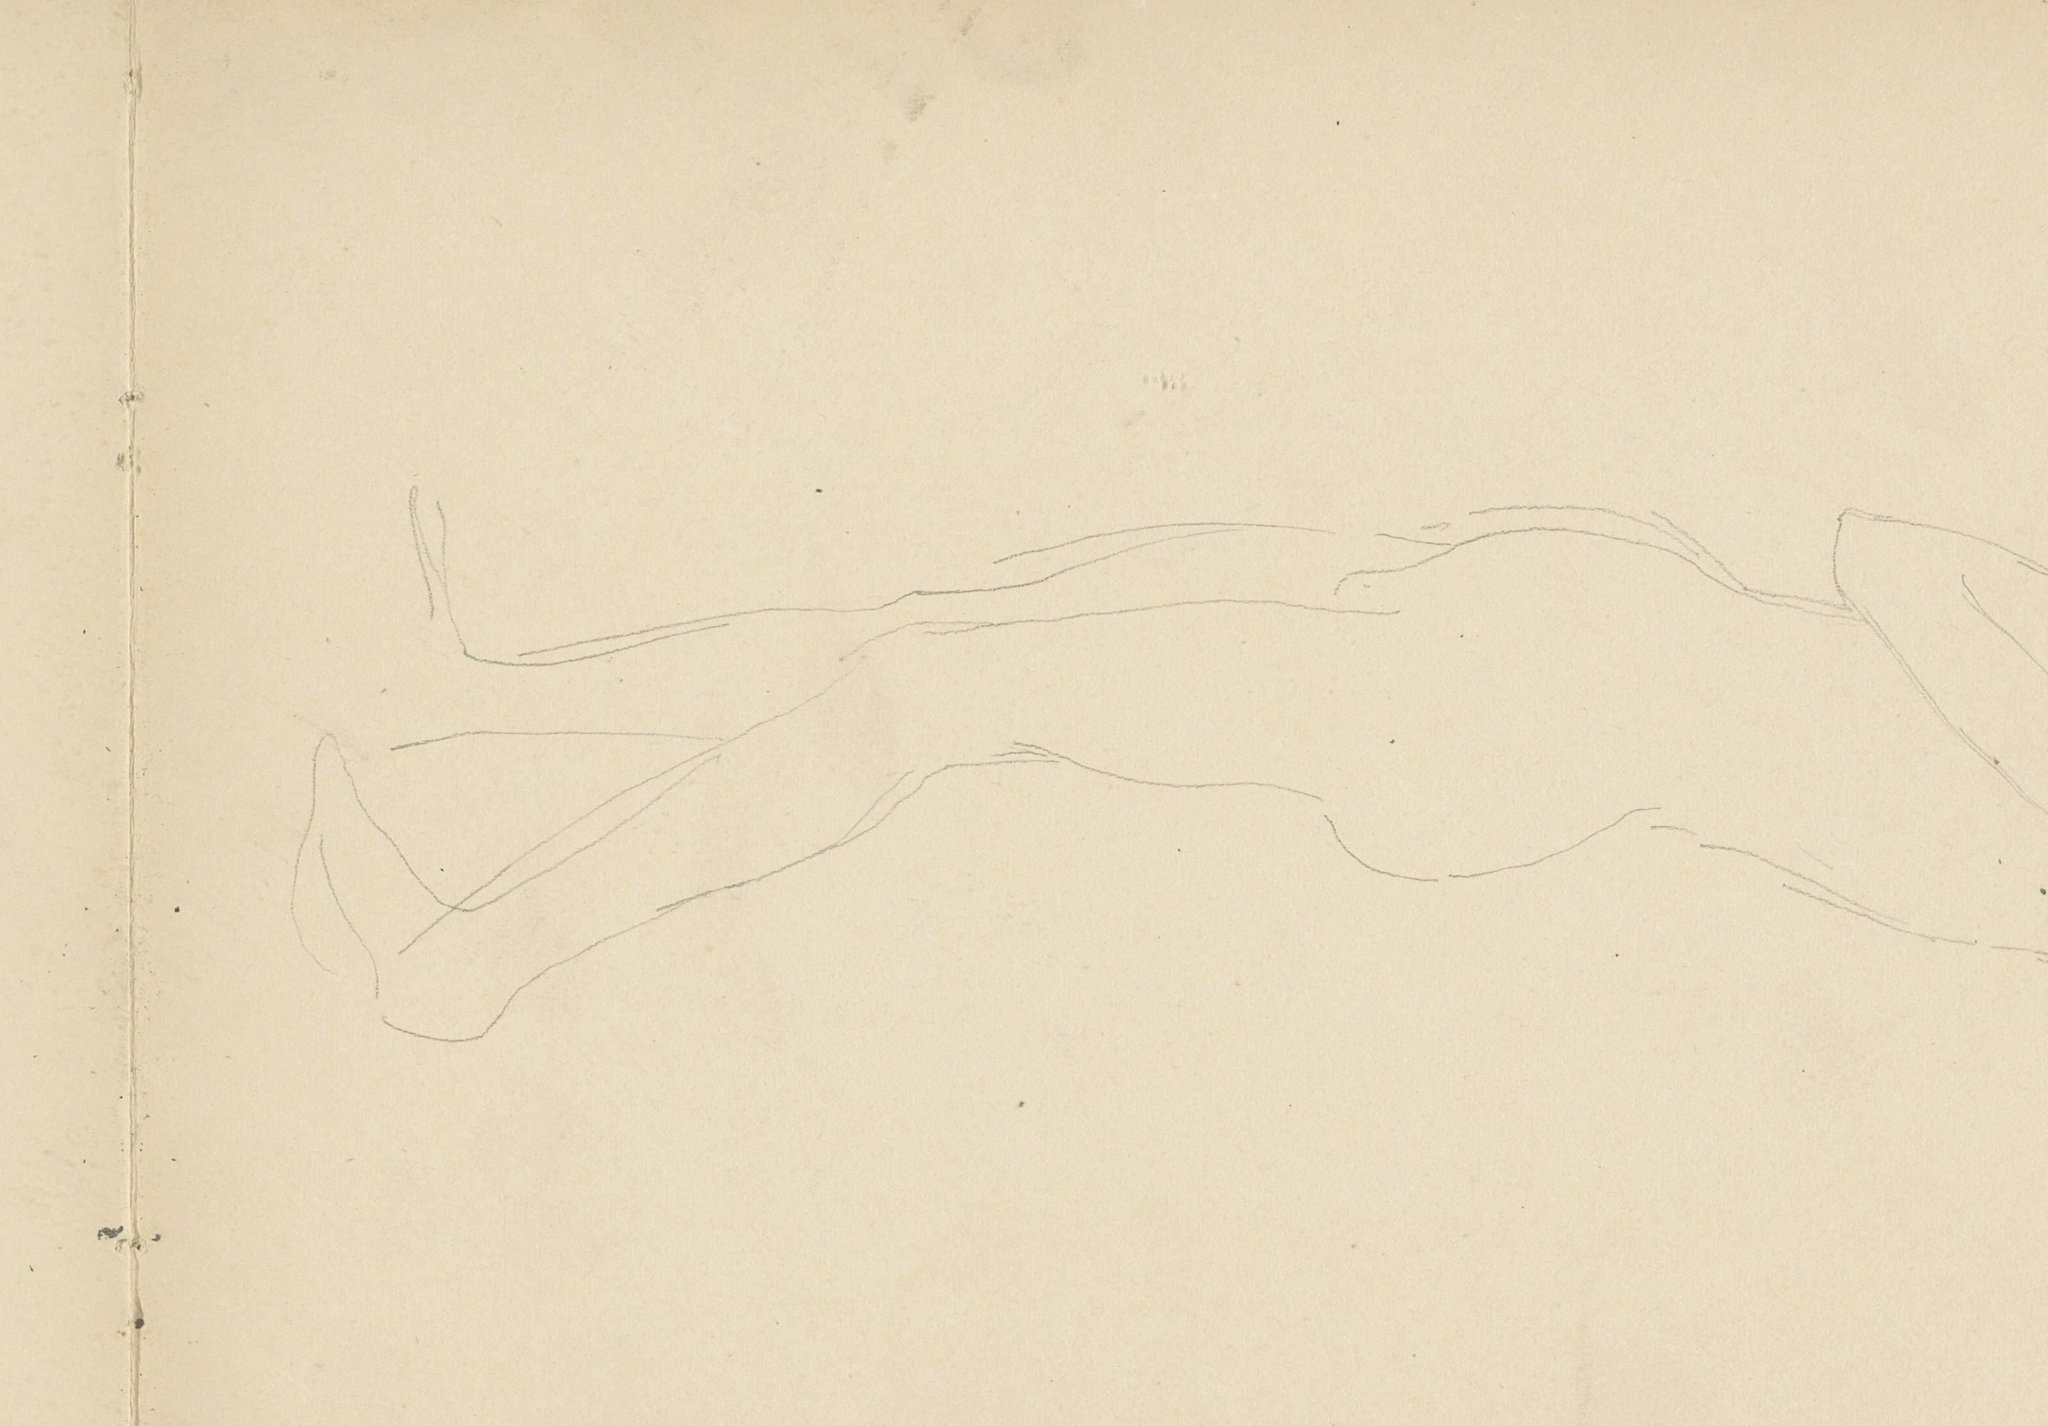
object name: sketchbook leaf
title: Staand naakt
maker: antoon derkinderen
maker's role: draughtsman, painter, print maker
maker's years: 1859-1925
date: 1869-1925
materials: paper, pencil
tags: the (nude) human figure; 'corpo humano' (ripa)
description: Blad 5 recto uit een schetsboek met 28 bladen.